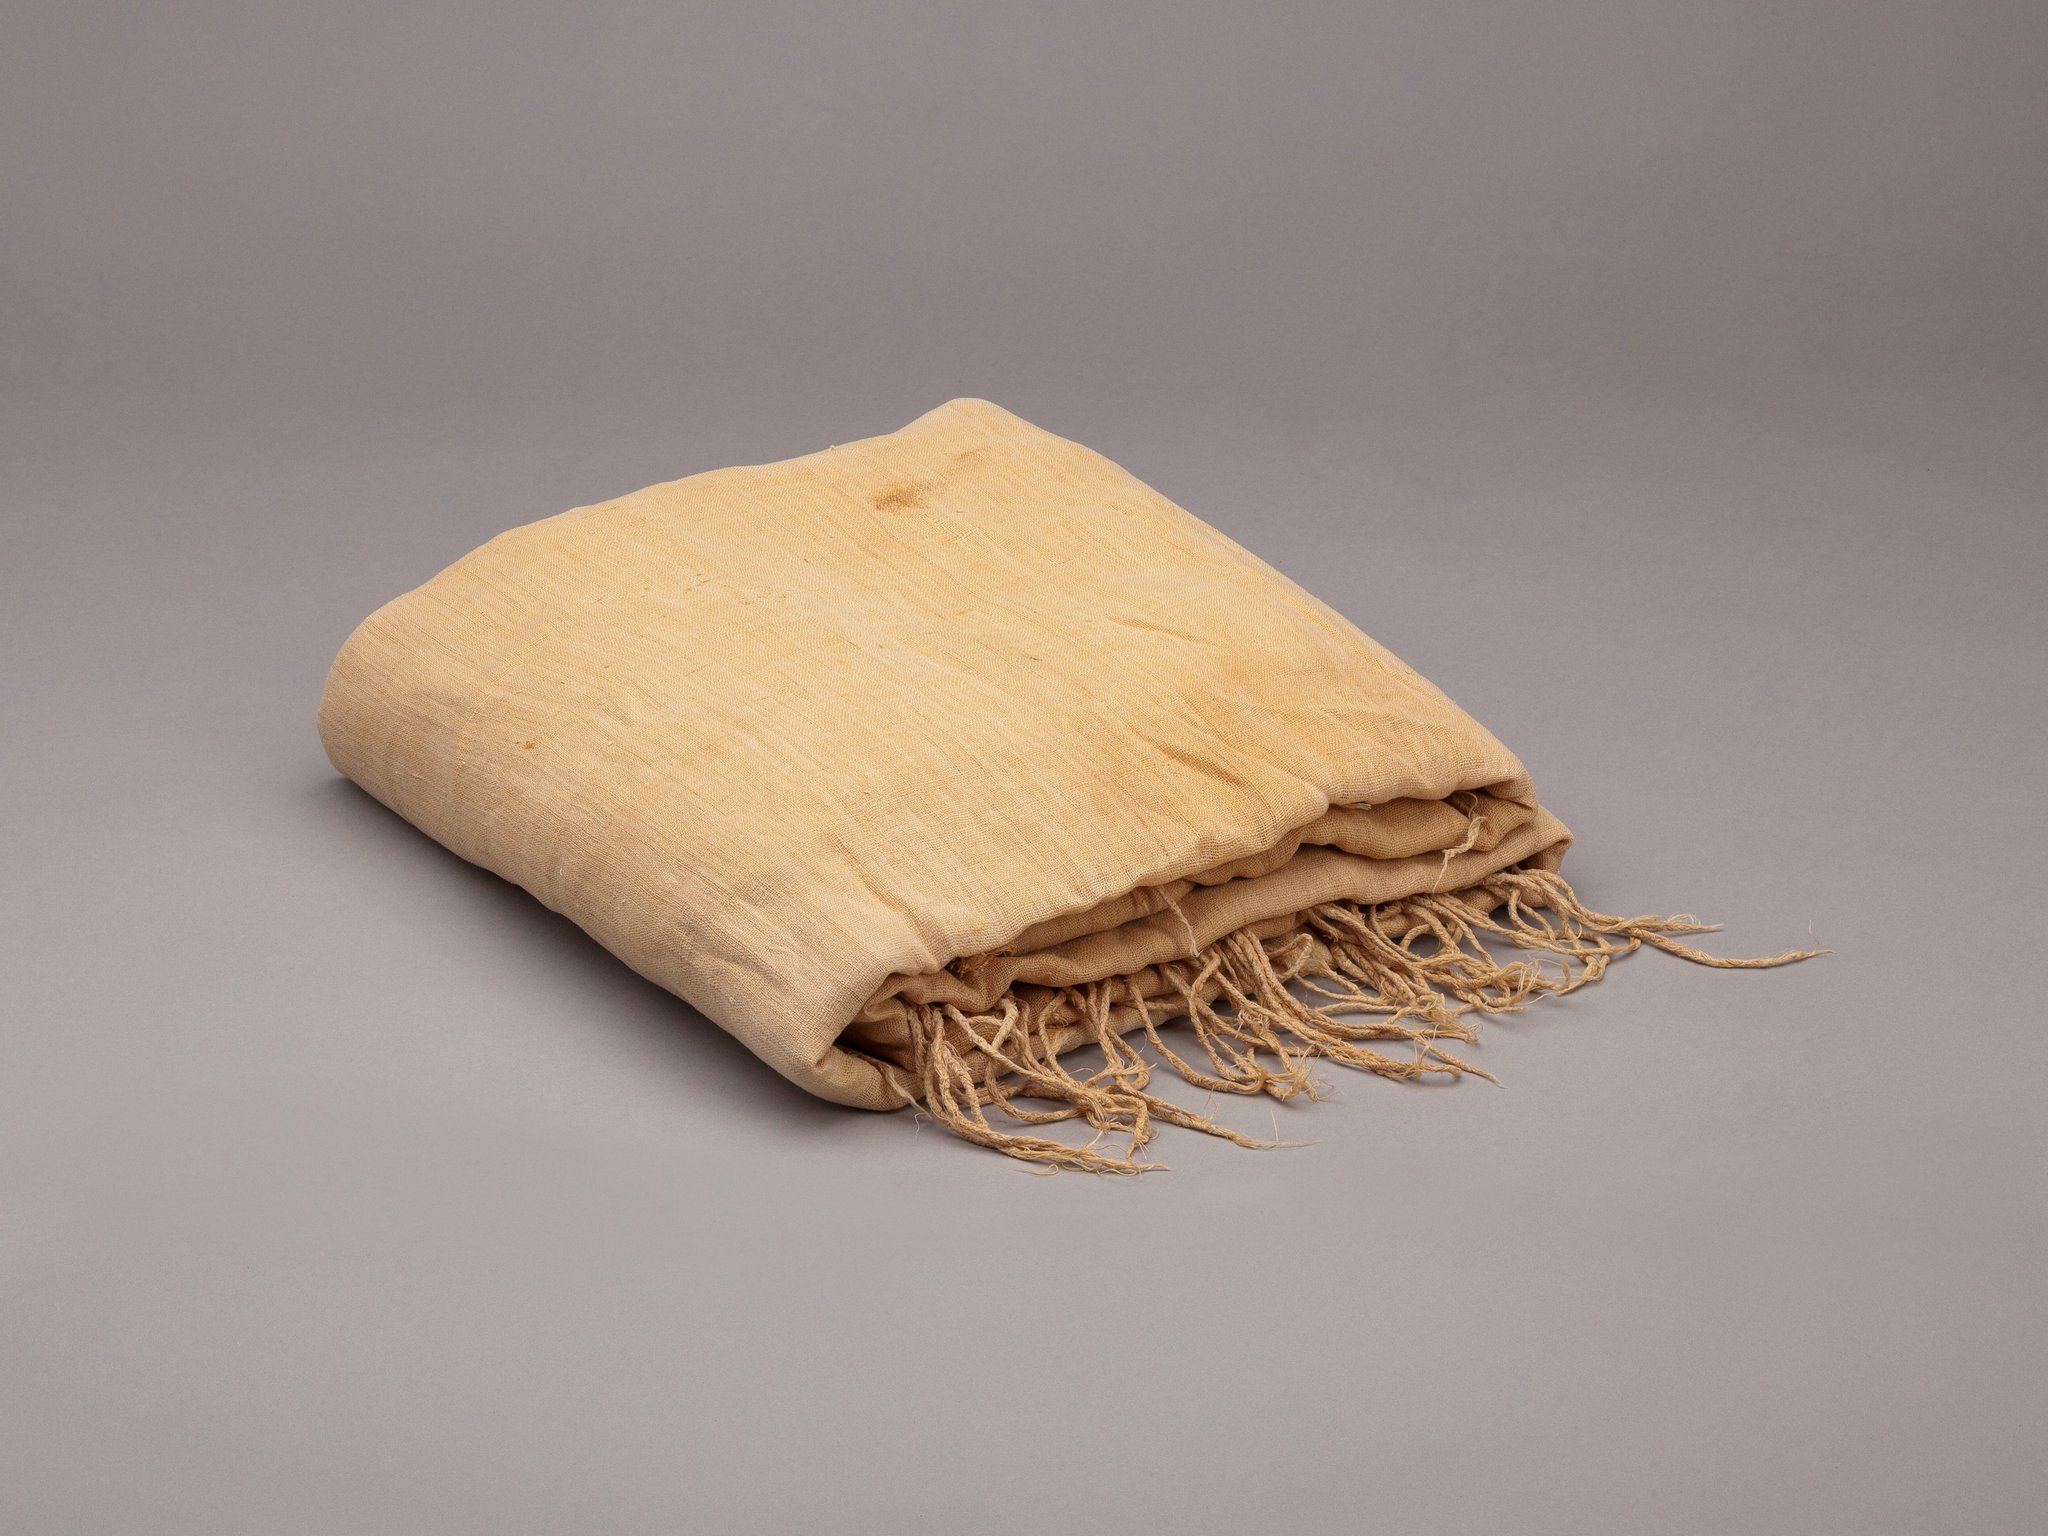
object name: linen mark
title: Sheet, linen mark, medium spin, medium weave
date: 1492-1473 BCE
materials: linen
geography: egypt